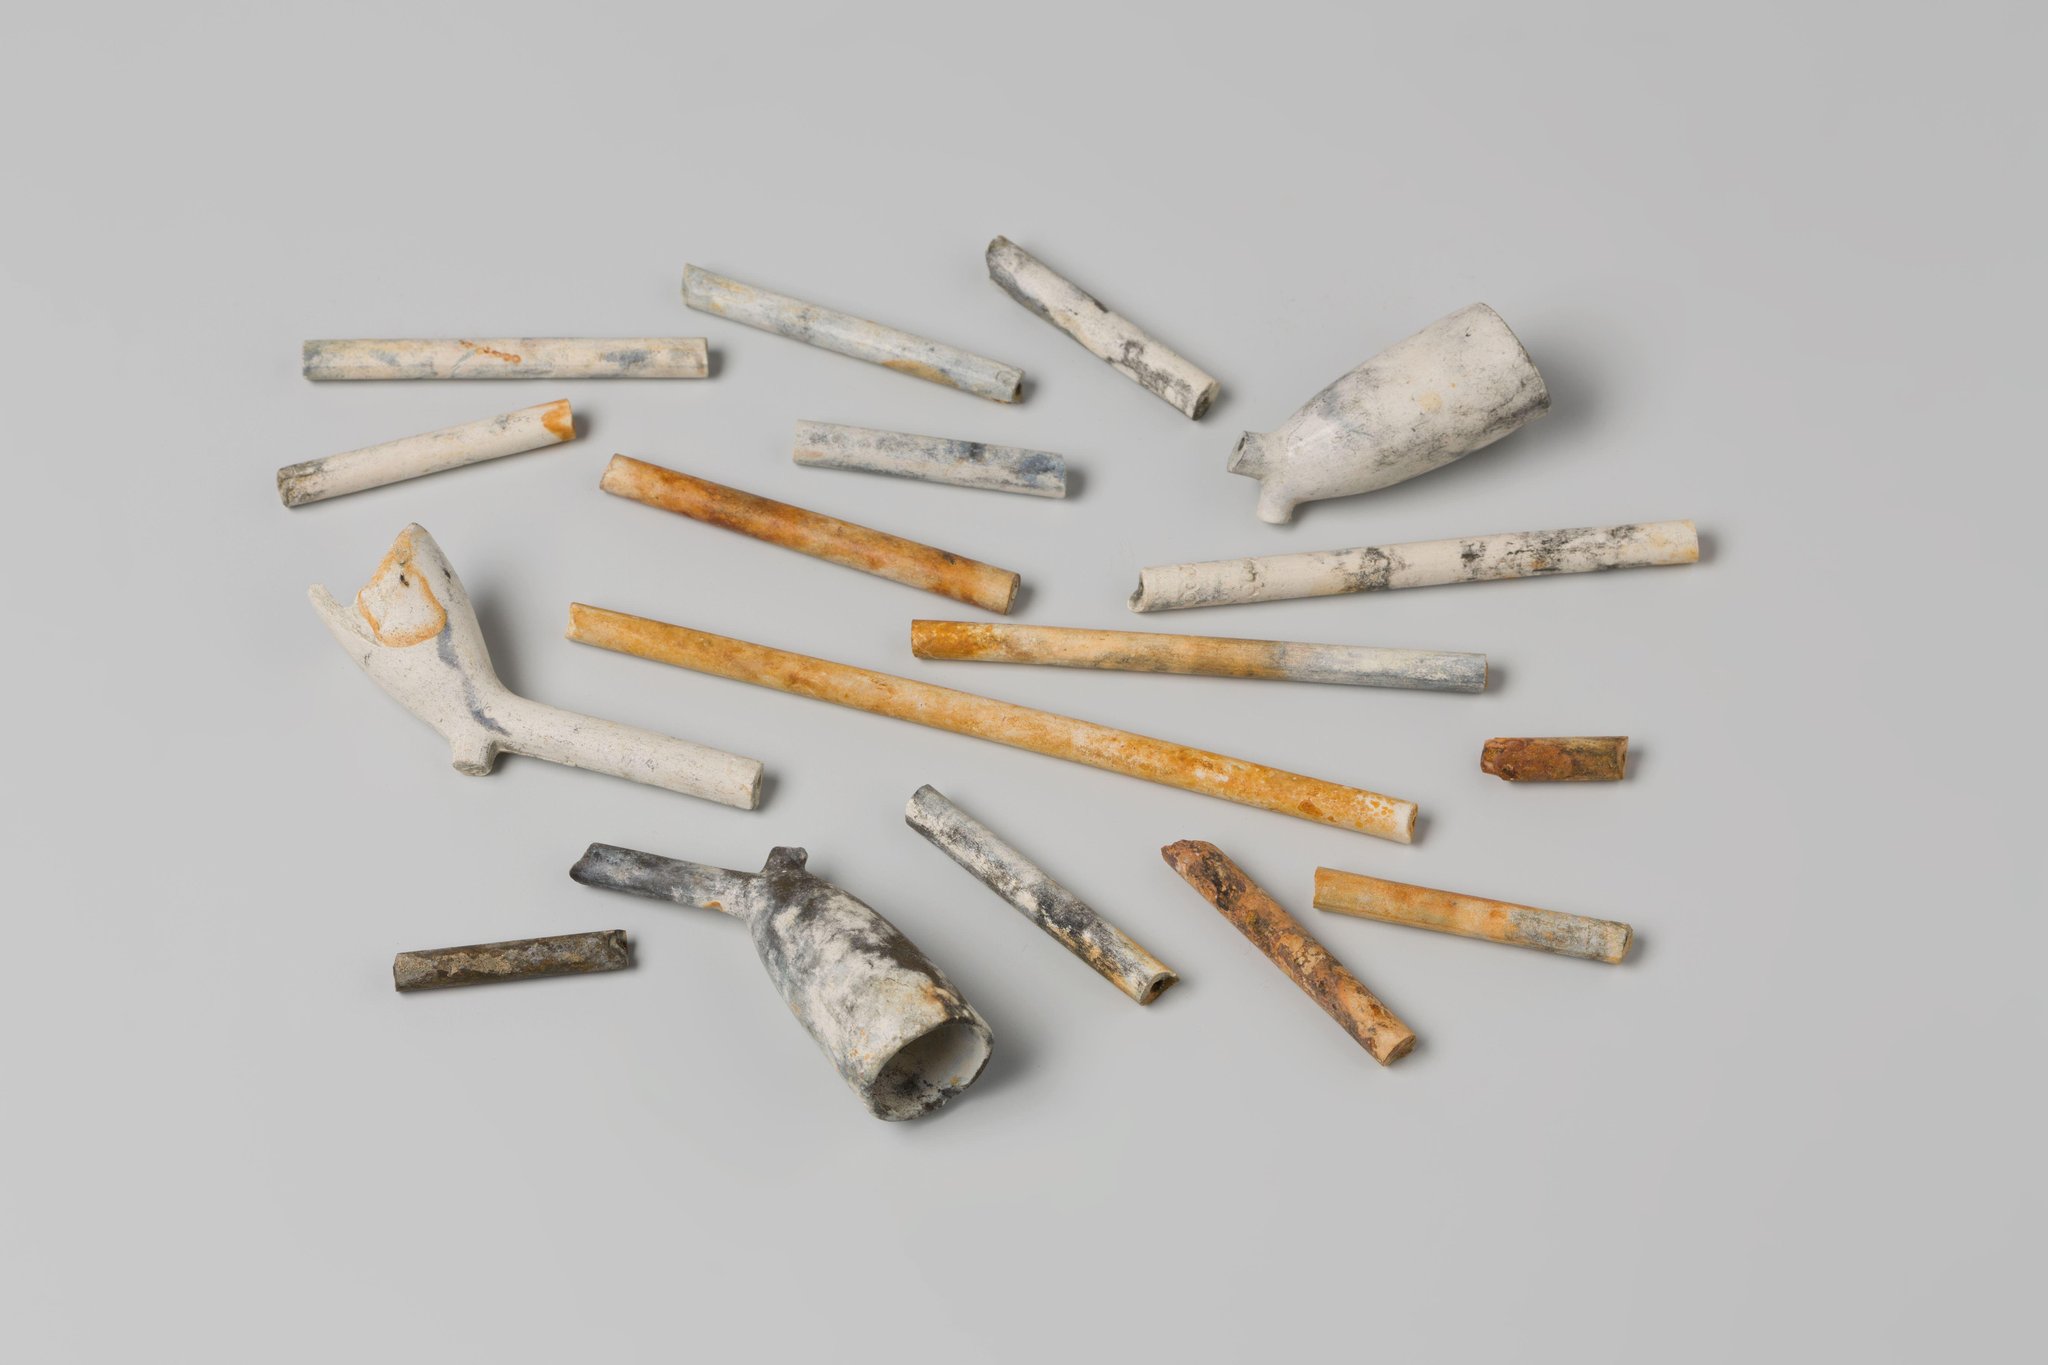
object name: pipe bowl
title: Fragmenten van pijpenkoppen en pijpenstelen uit het wrak van de Oost-Indiëvaarder 't Vliegend Hart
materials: clay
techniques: firing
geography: gouda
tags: 't vliegend hart (schip), verenigde oostindische compagnie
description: Een kop met een stuk steel van een aarden Goudse pijp, hielmerk onleesbaar, wit met zwartige aanslag. Een kop zonder steel met hielmerk 'vinkenkorfje'. Een gebroken kop met hielmerk SVS. En 14 stukken van stelen zonder versiering.